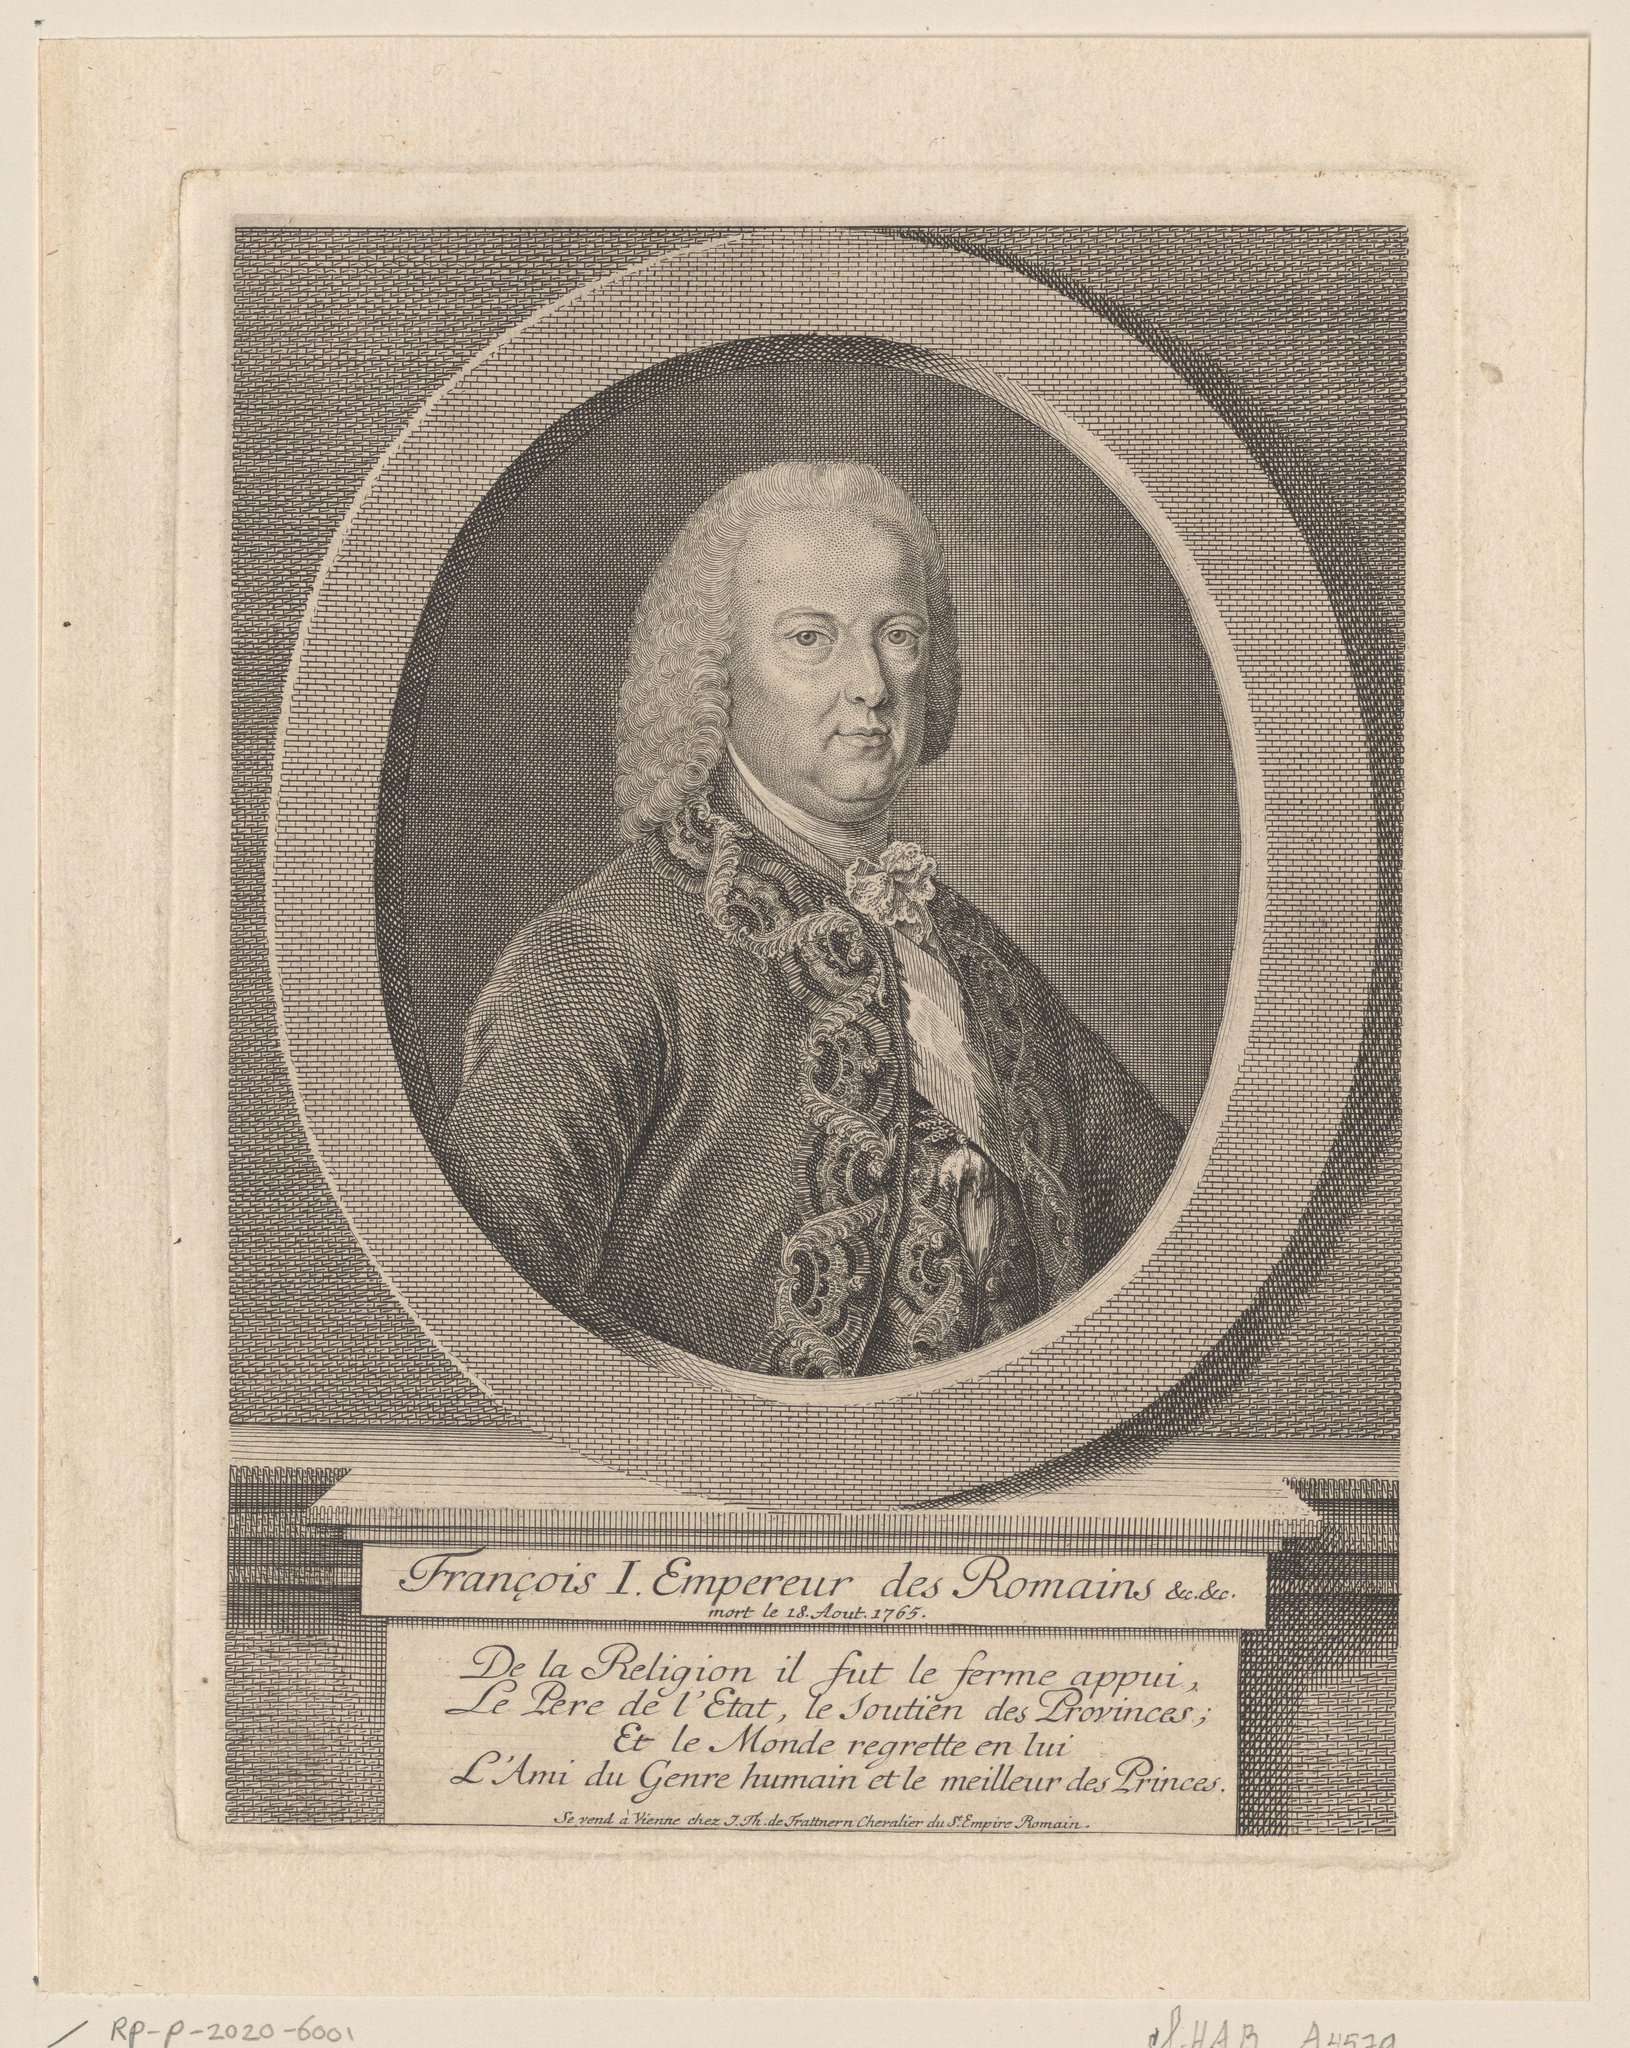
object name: print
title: Portret van keizer Frans I Stefan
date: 1765-1798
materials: paper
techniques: engraving, etching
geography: vienna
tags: frans i stefan (duits keizer), historical persons, emperor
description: Met vierregelig vers in het Frans onder het portret.